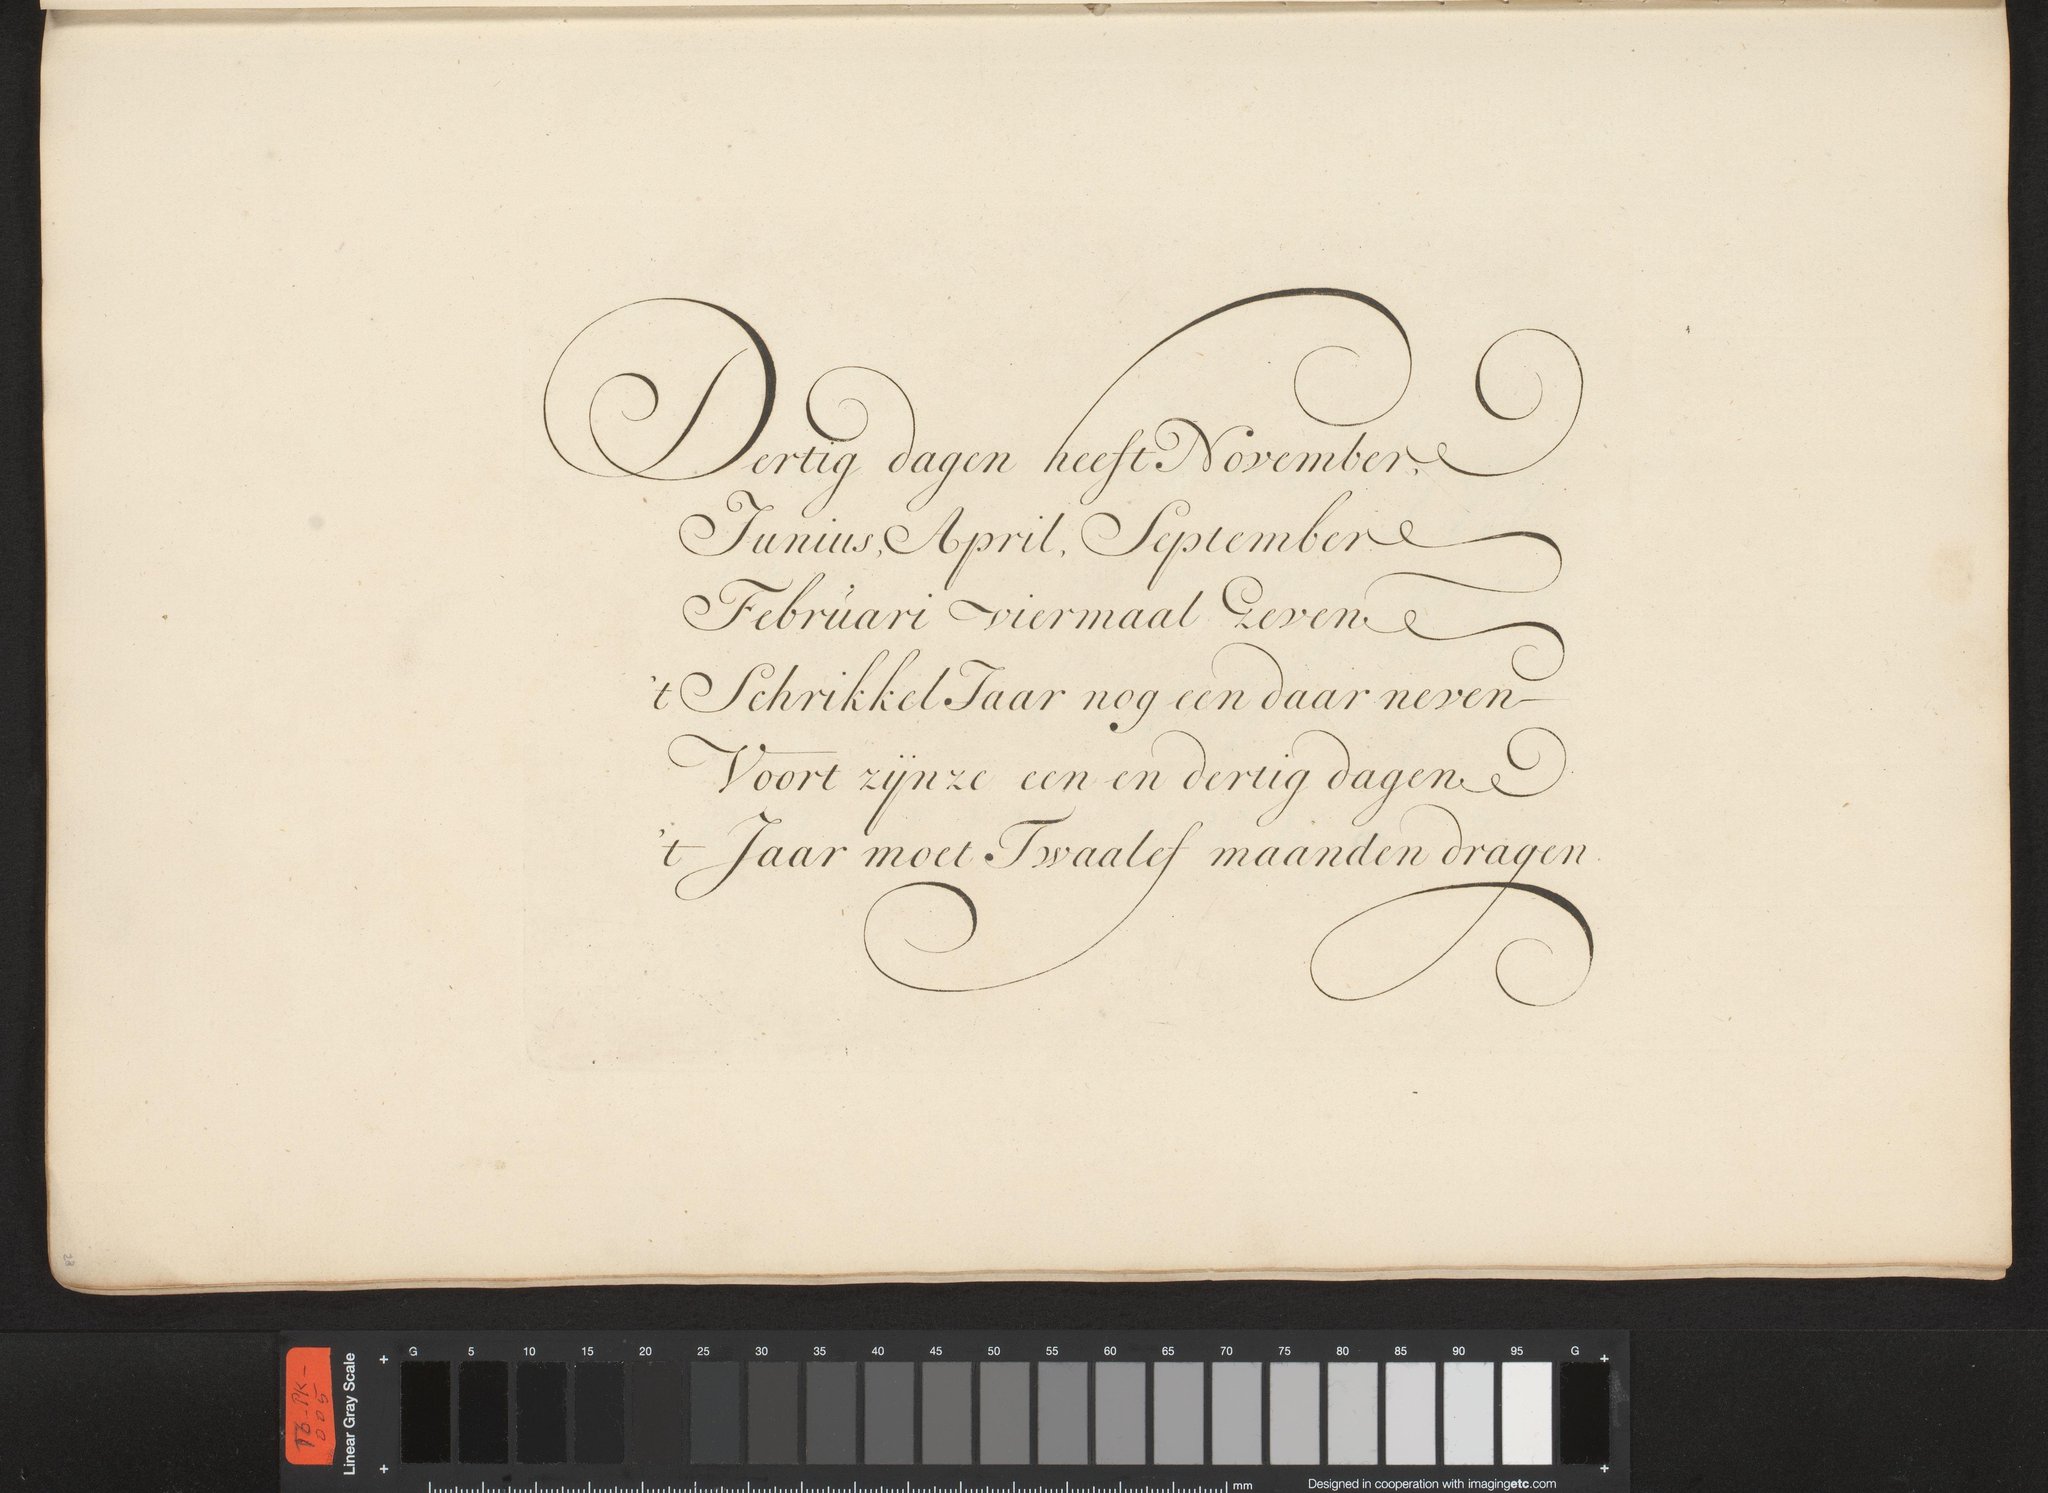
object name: album leaf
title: Schrijfvoorbeeld: Dertig dagen heeft November (...)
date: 1660-1751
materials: paper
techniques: engraving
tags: calligraphy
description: Schrijfvoorbeeld met zes regels tekst in het Nederlands: Dertig dagen heeft November ... De prent maakt deel uit van een album